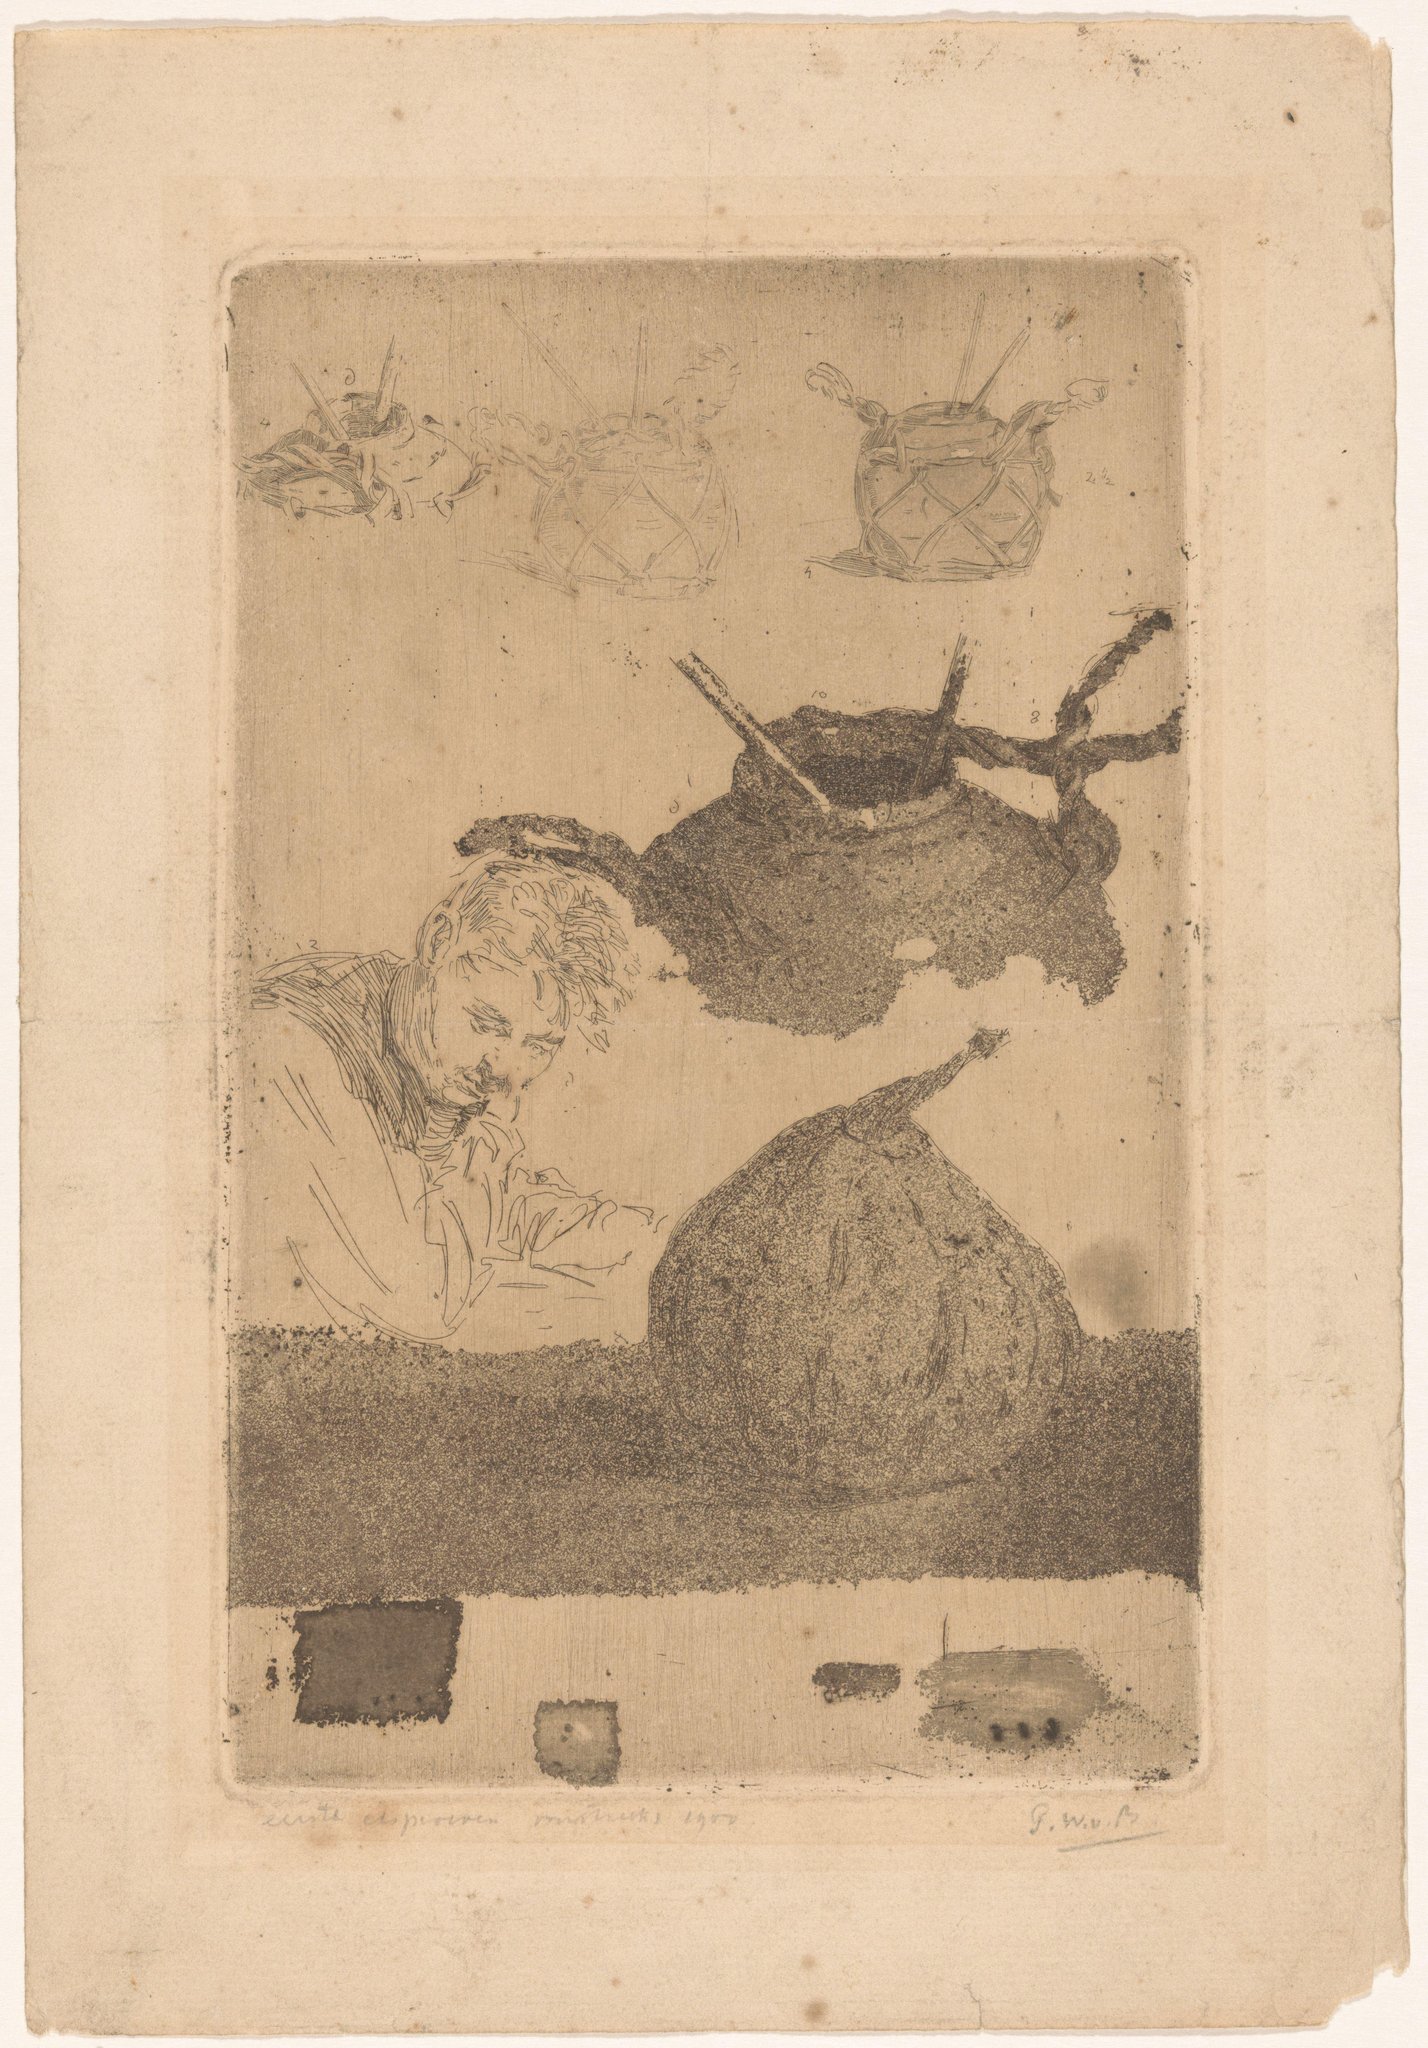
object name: print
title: Eerste etsproeven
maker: pieter willem van baarsel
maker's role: draughtsman, painter, print maker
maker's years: 1879-1949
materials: paper, ink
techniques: aquatint, etching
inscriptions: monogram: ‘P.W.v. B.’, collector's mark: Lugt 2228, inscription: ‘eerste etsproeven voordruk [?] 190[?]’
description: Compositie met een man op schouderhoogte, verschillende potten, rechthoeken en een pompoen.